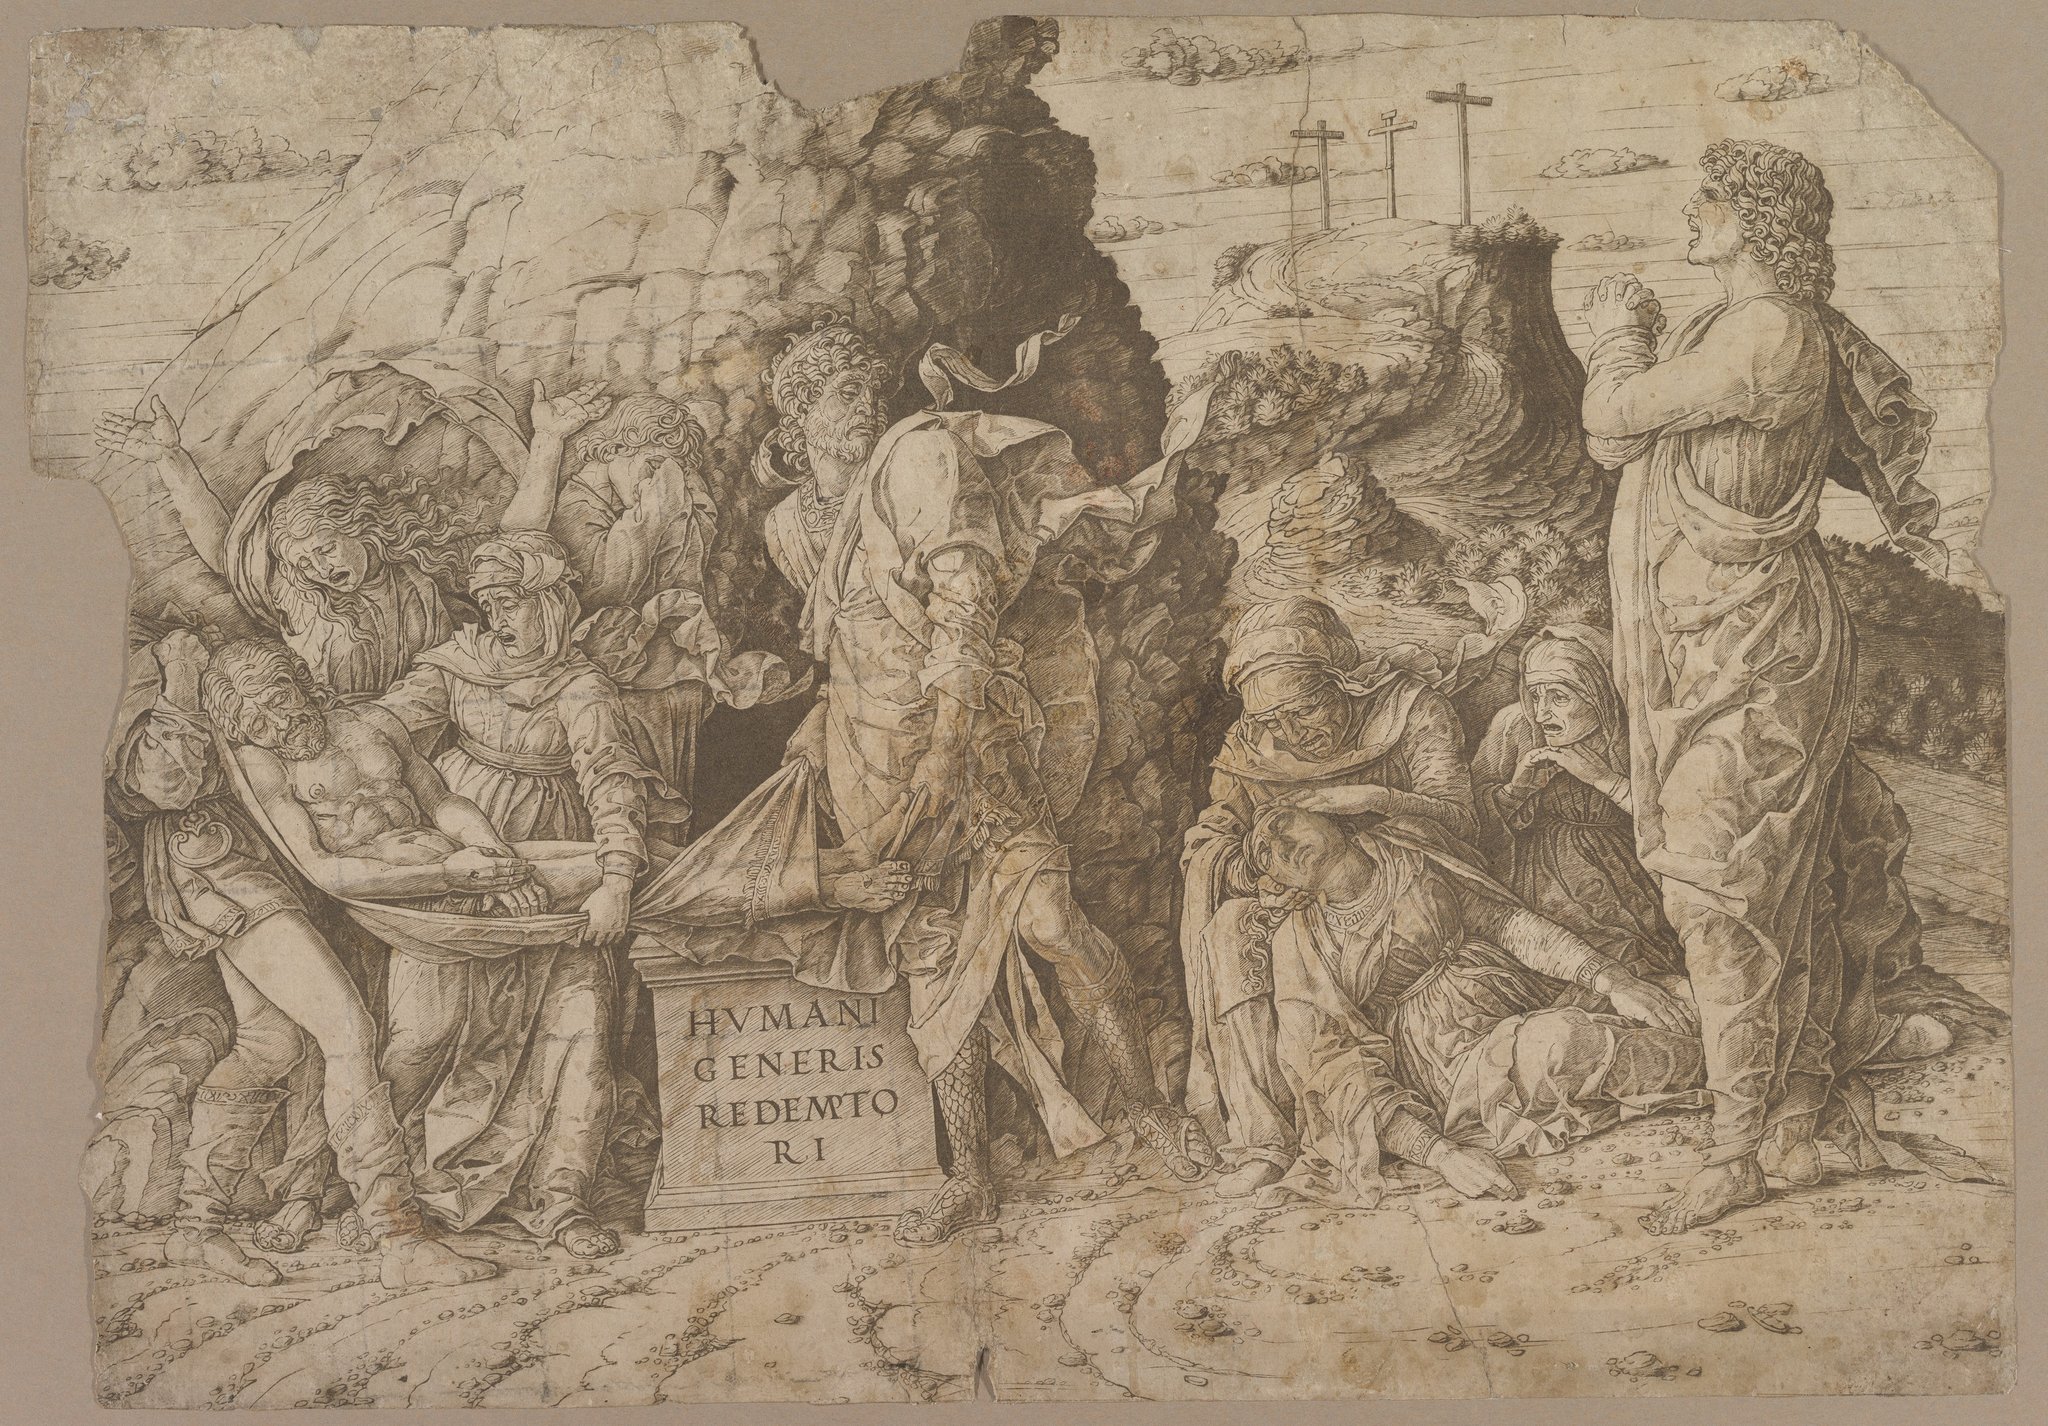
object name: print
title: The Entombment of Christ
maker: andrea mantegna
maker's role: artist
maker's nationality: italian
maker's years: 1431-1506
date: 1475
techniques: drypoint, engraving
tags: sadness,men,christ,virgin mary,entombment